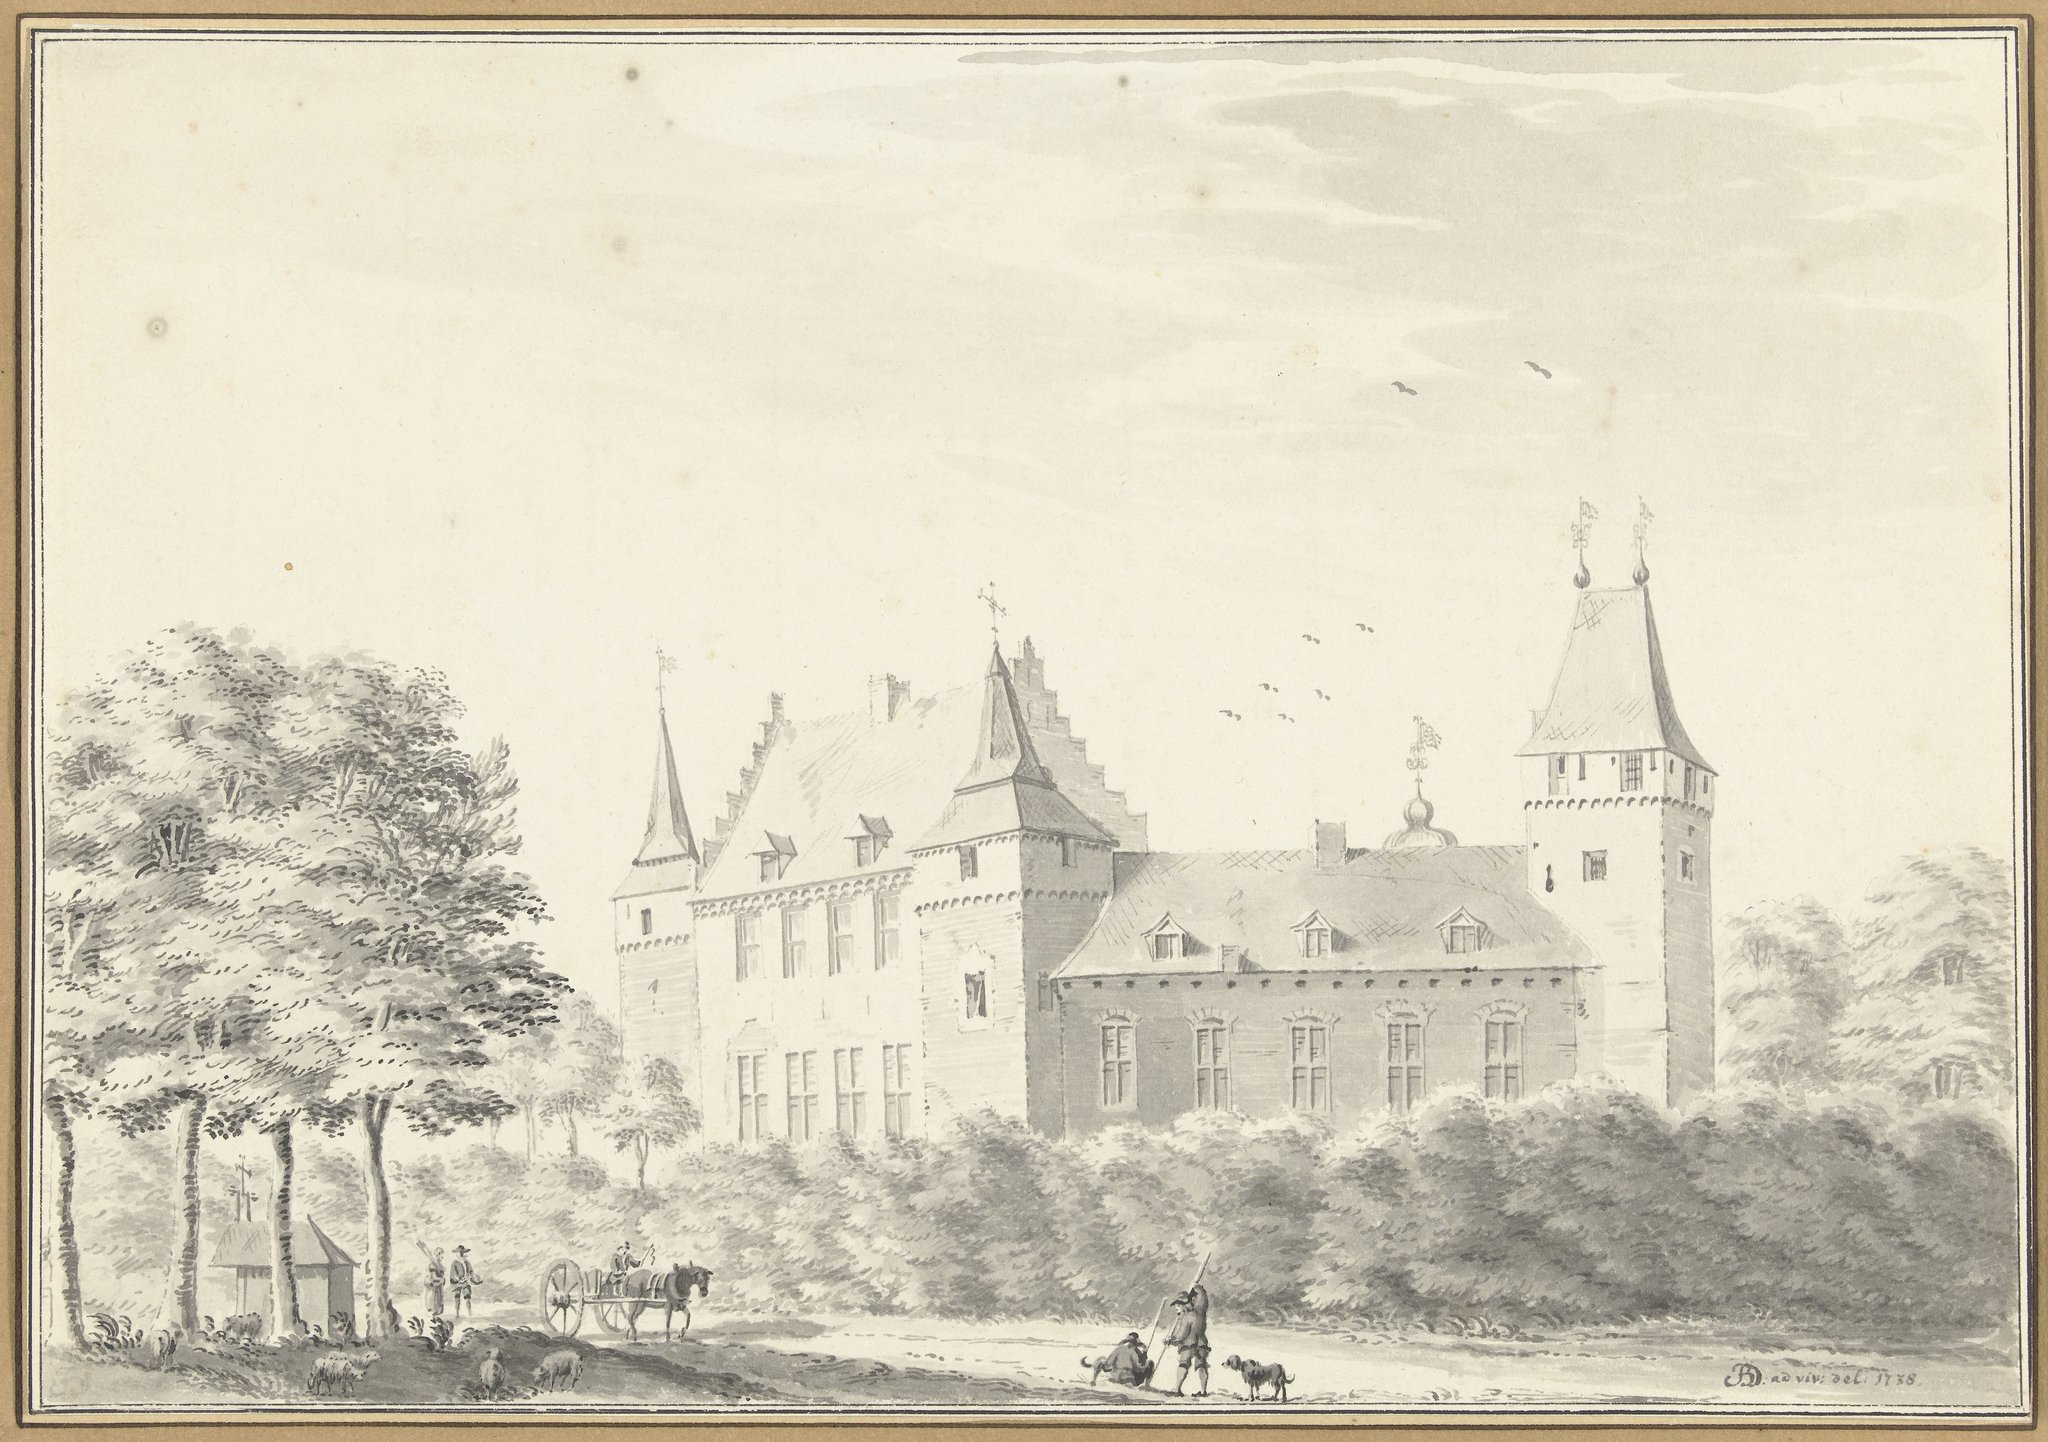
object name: drawing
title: De Vrijheerlijkheid Elsem in't Guliksche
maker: Anonymous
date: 1738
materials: ink, paper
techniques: brush, pen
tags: castle